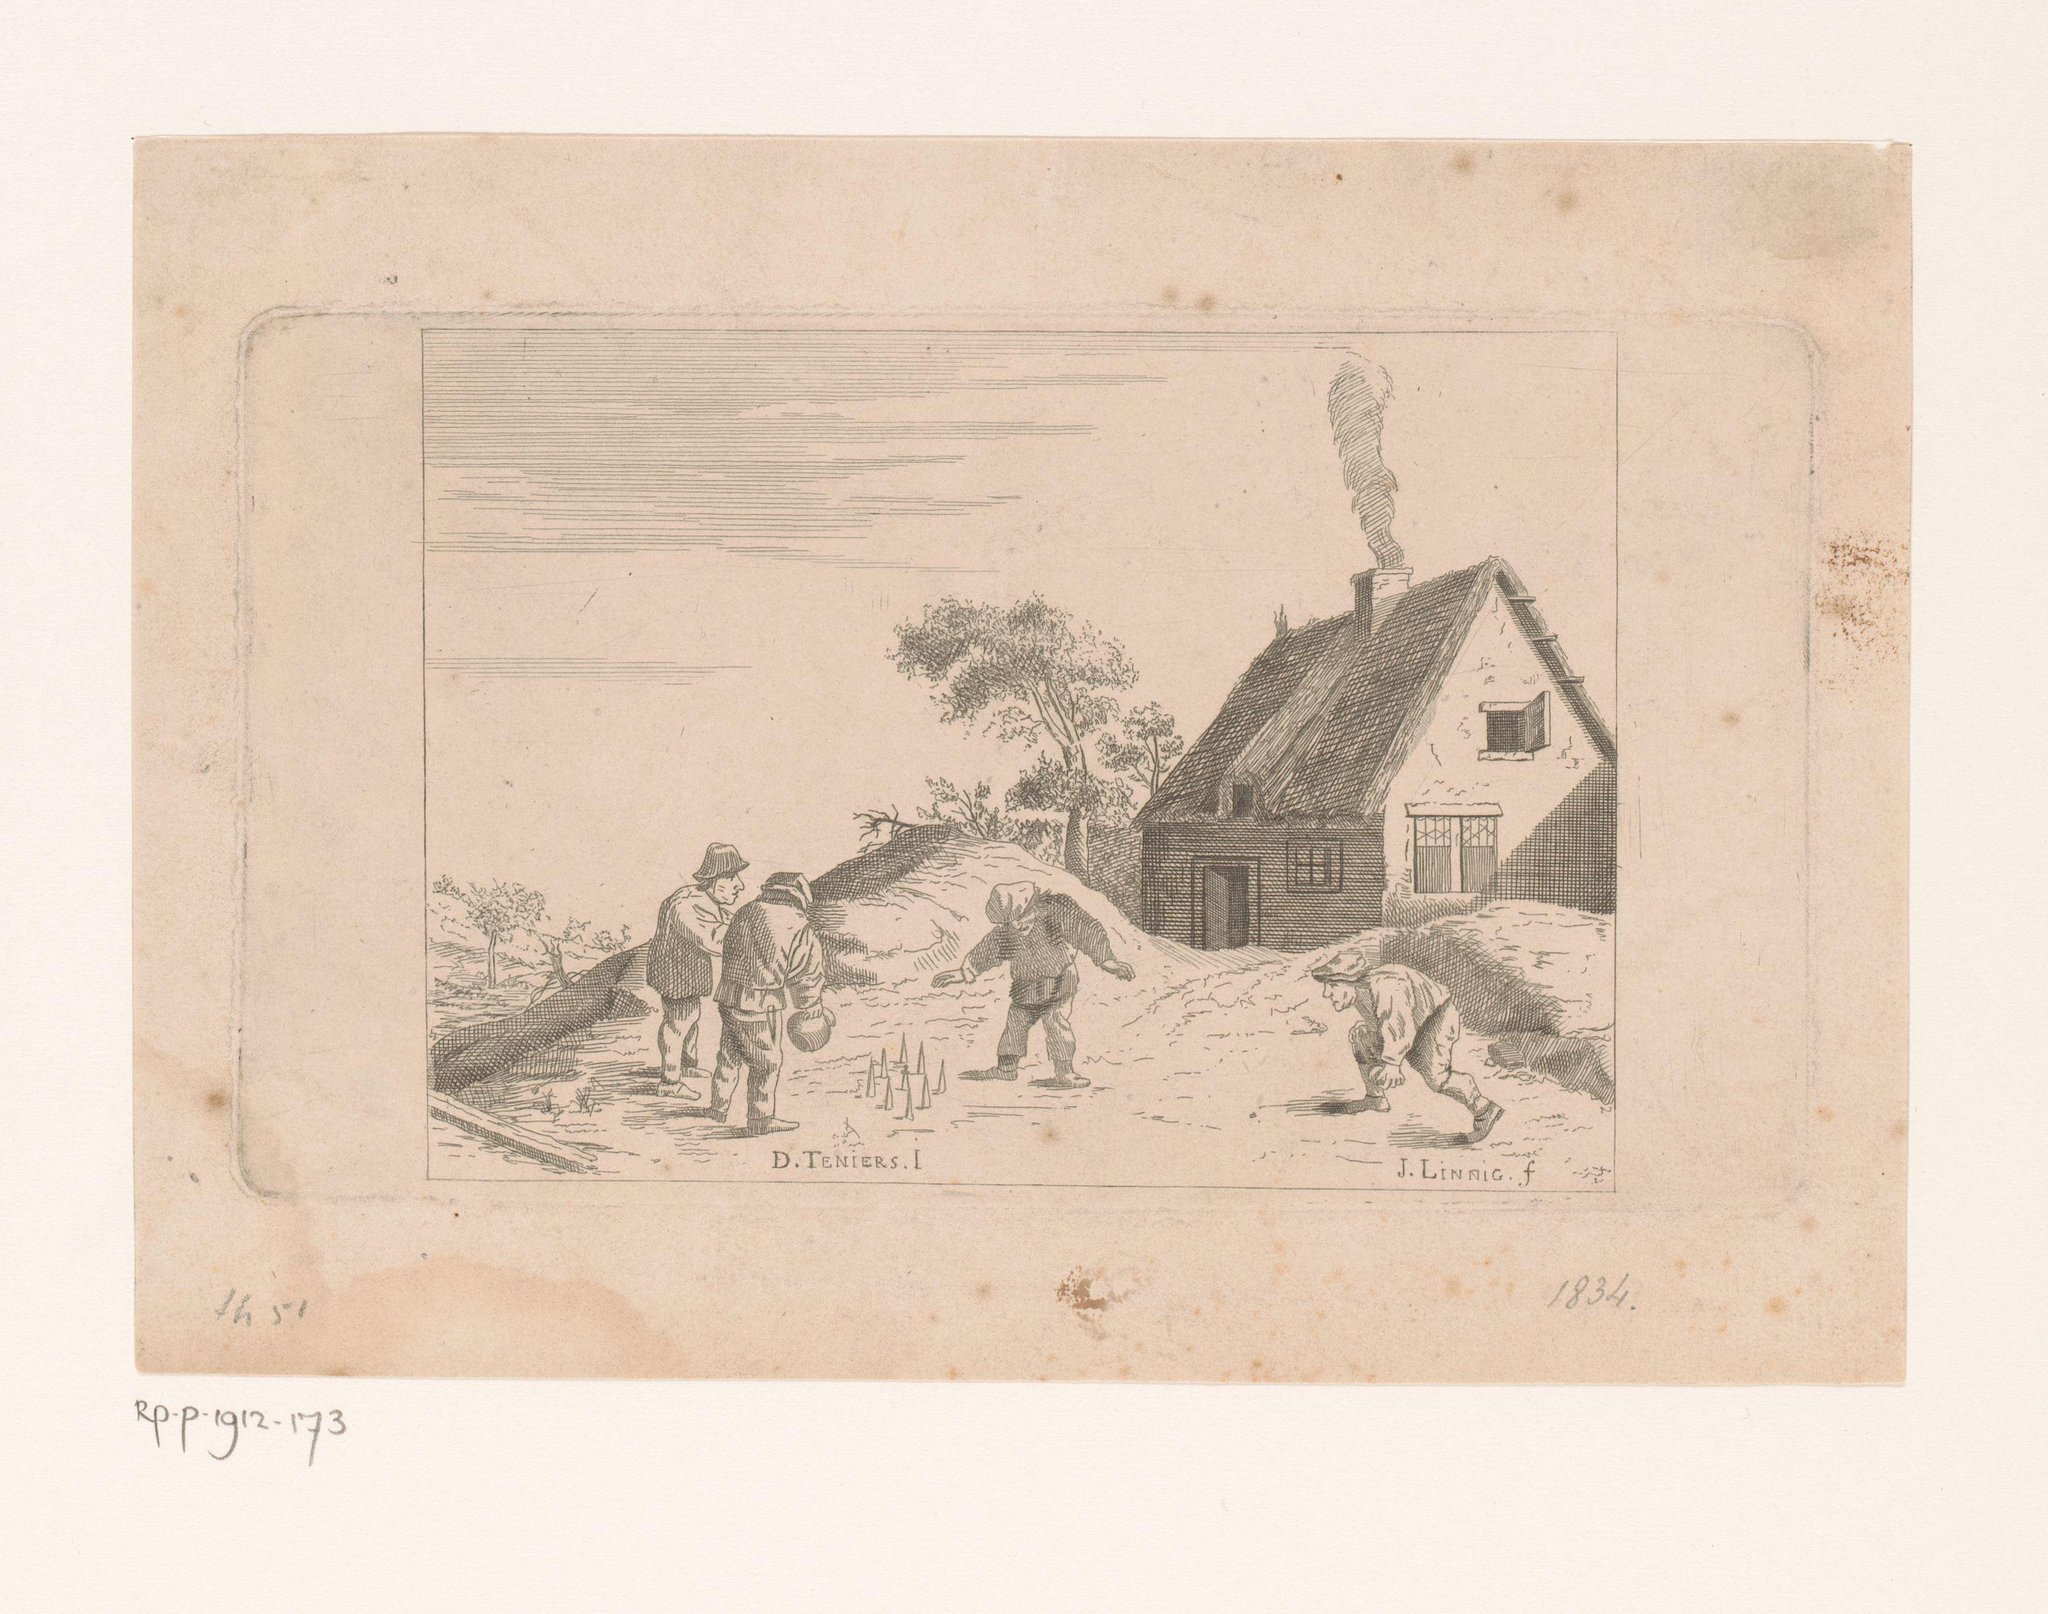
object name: print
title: Landschap met kegelaars bij een woning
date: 1834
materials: paper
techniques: etching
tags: ninepins, skittles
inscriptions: collector's mark: Lugt 2228, collector's mark: Lugt 1485